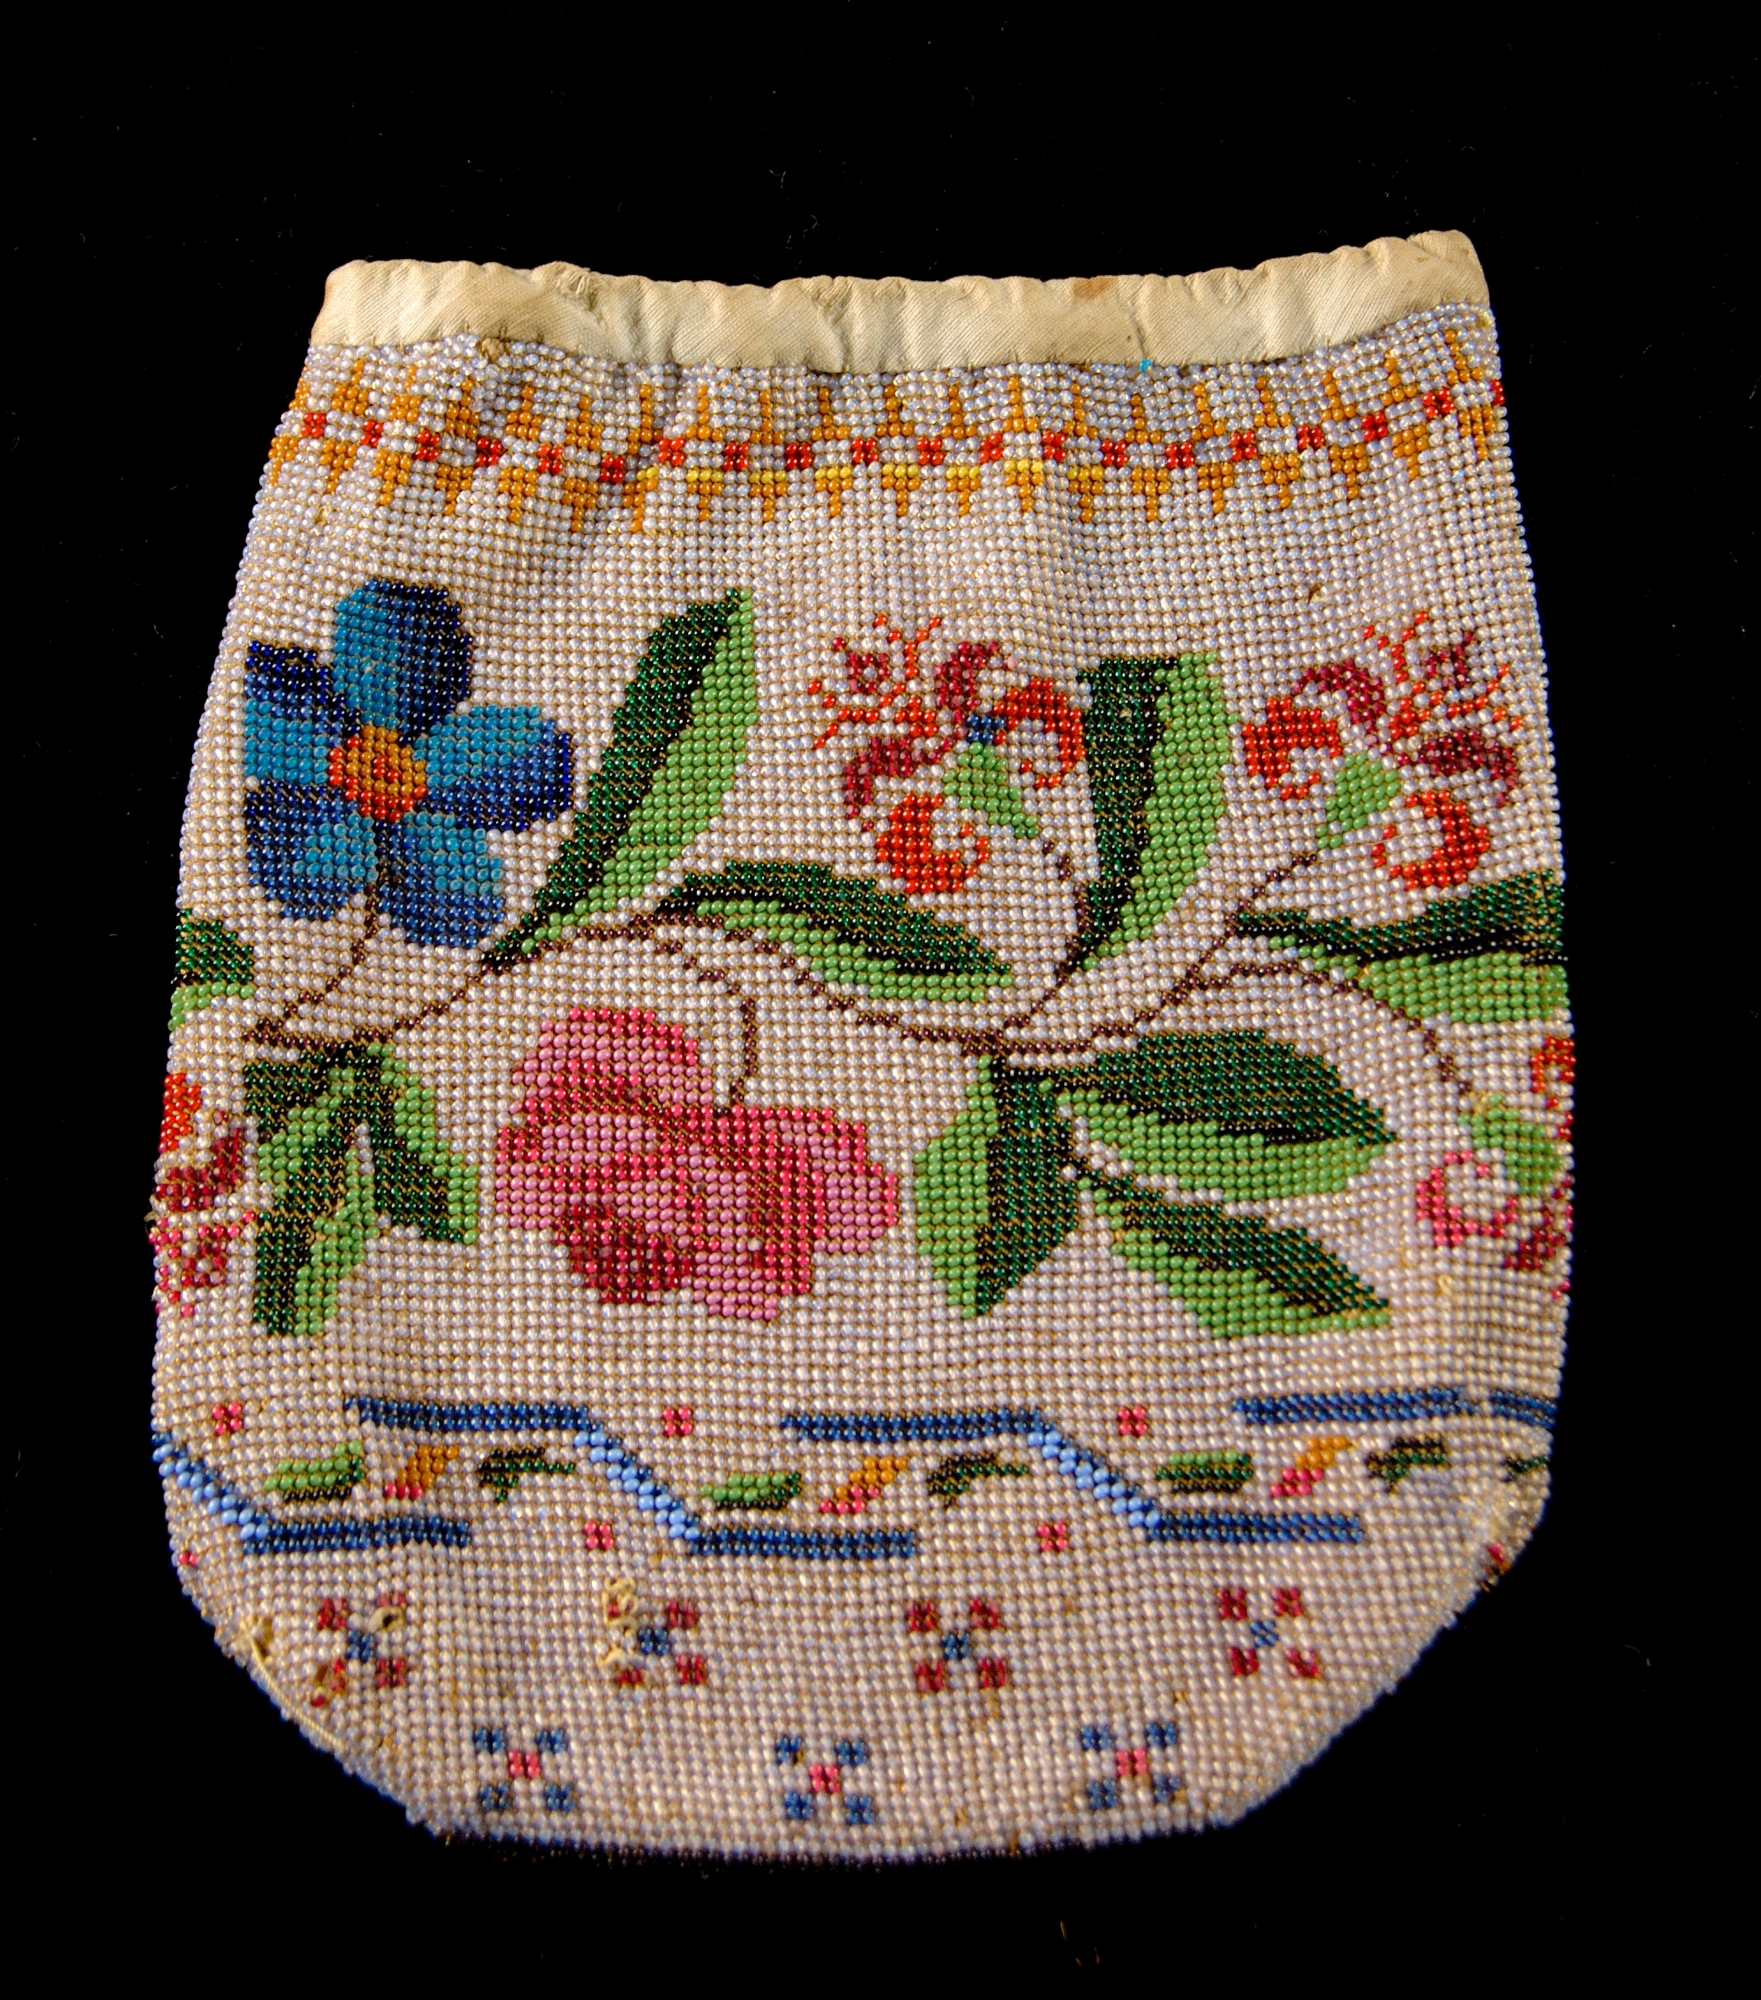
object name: pouch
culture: american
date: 1876-1900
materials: glass, linen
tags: flowers